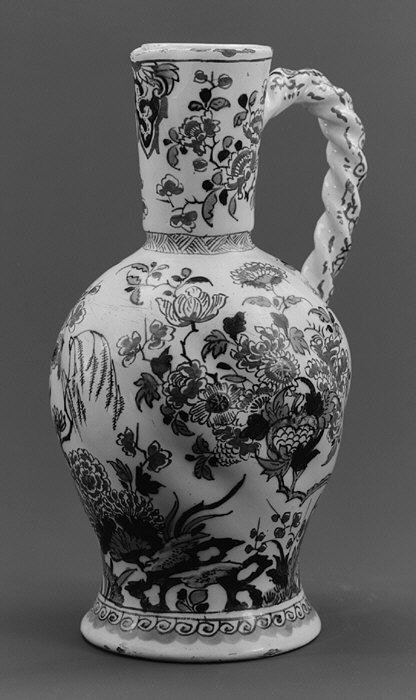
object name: krug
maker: rose factory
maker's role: maker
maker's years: 1662-1854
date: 1700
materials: earthenware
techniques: glazing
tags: flowers